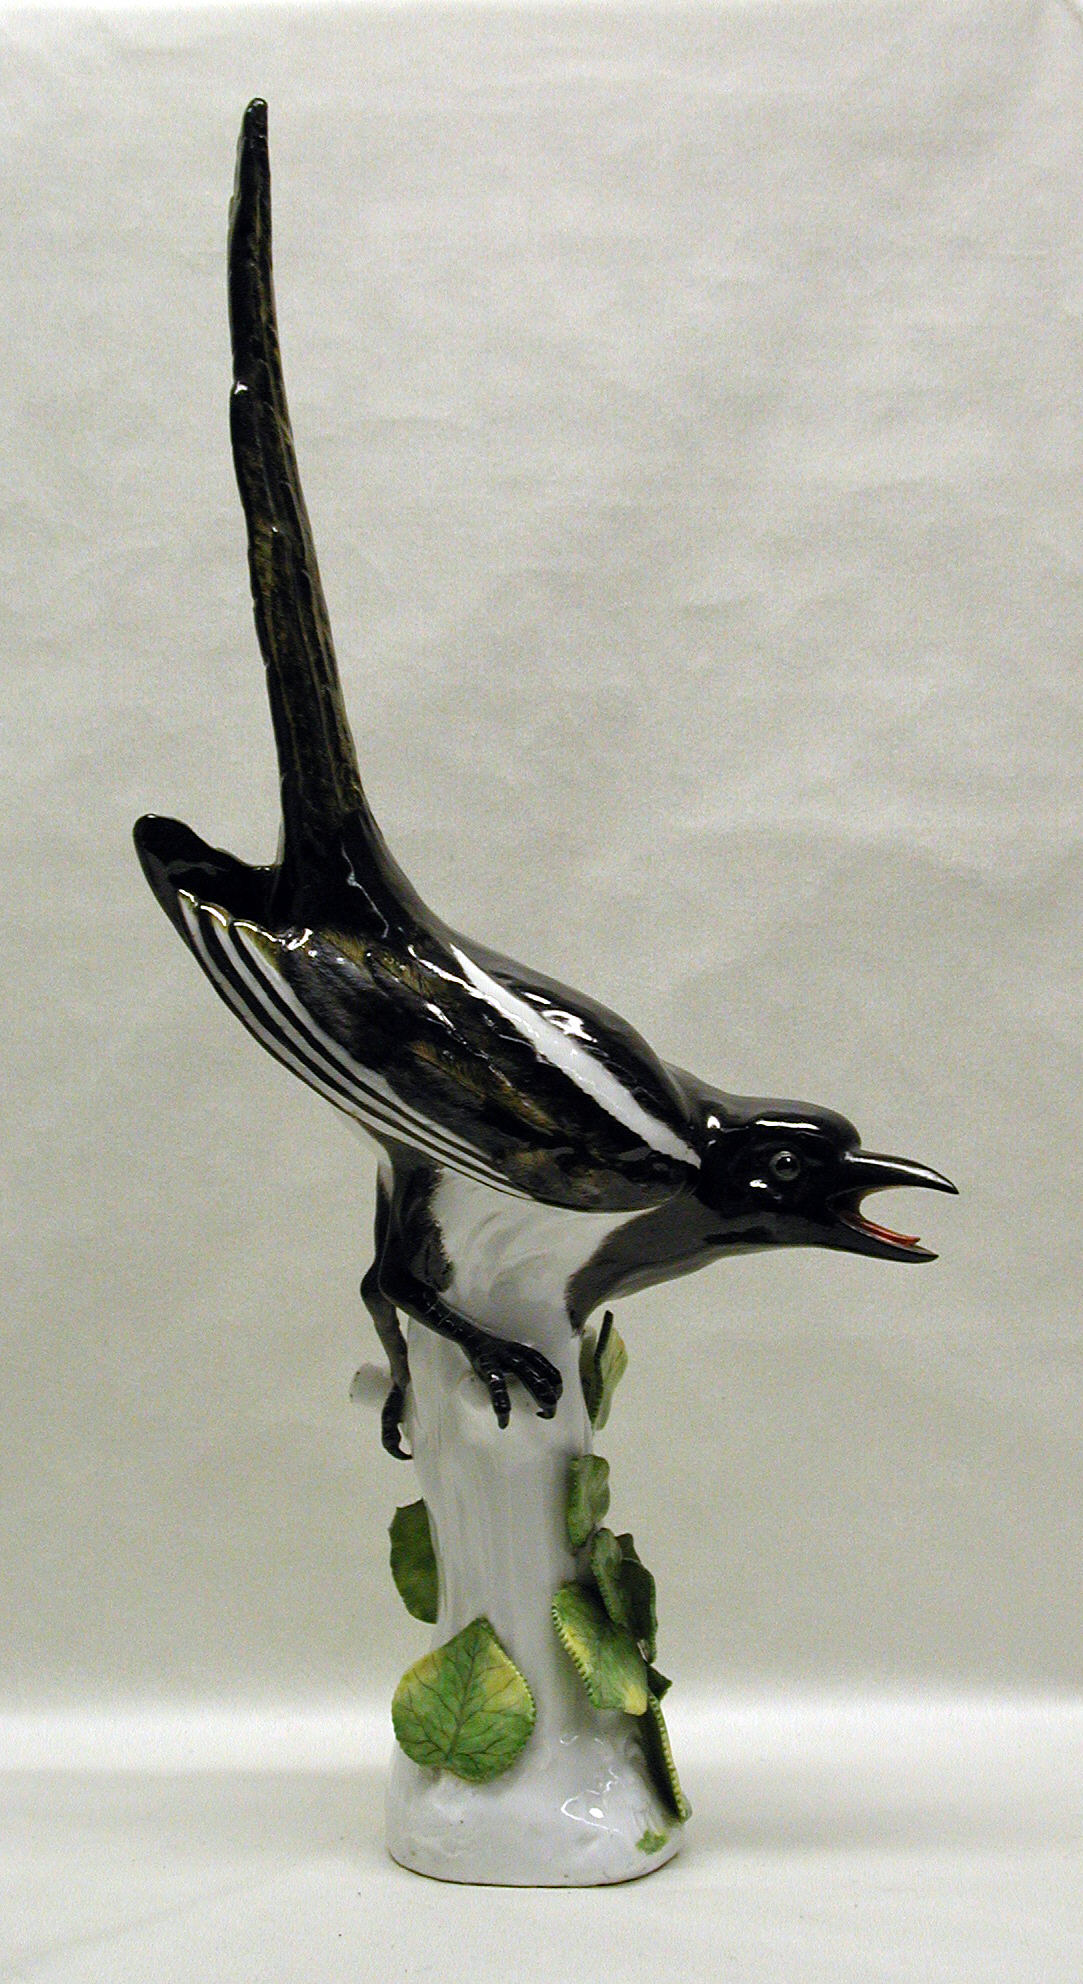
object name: figure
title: Magpie (one of a pair)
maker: meissen manufactory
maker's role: manufactory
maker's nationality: german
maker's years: 1710-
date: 1733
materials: hard paste porcelain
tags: birds,leaves